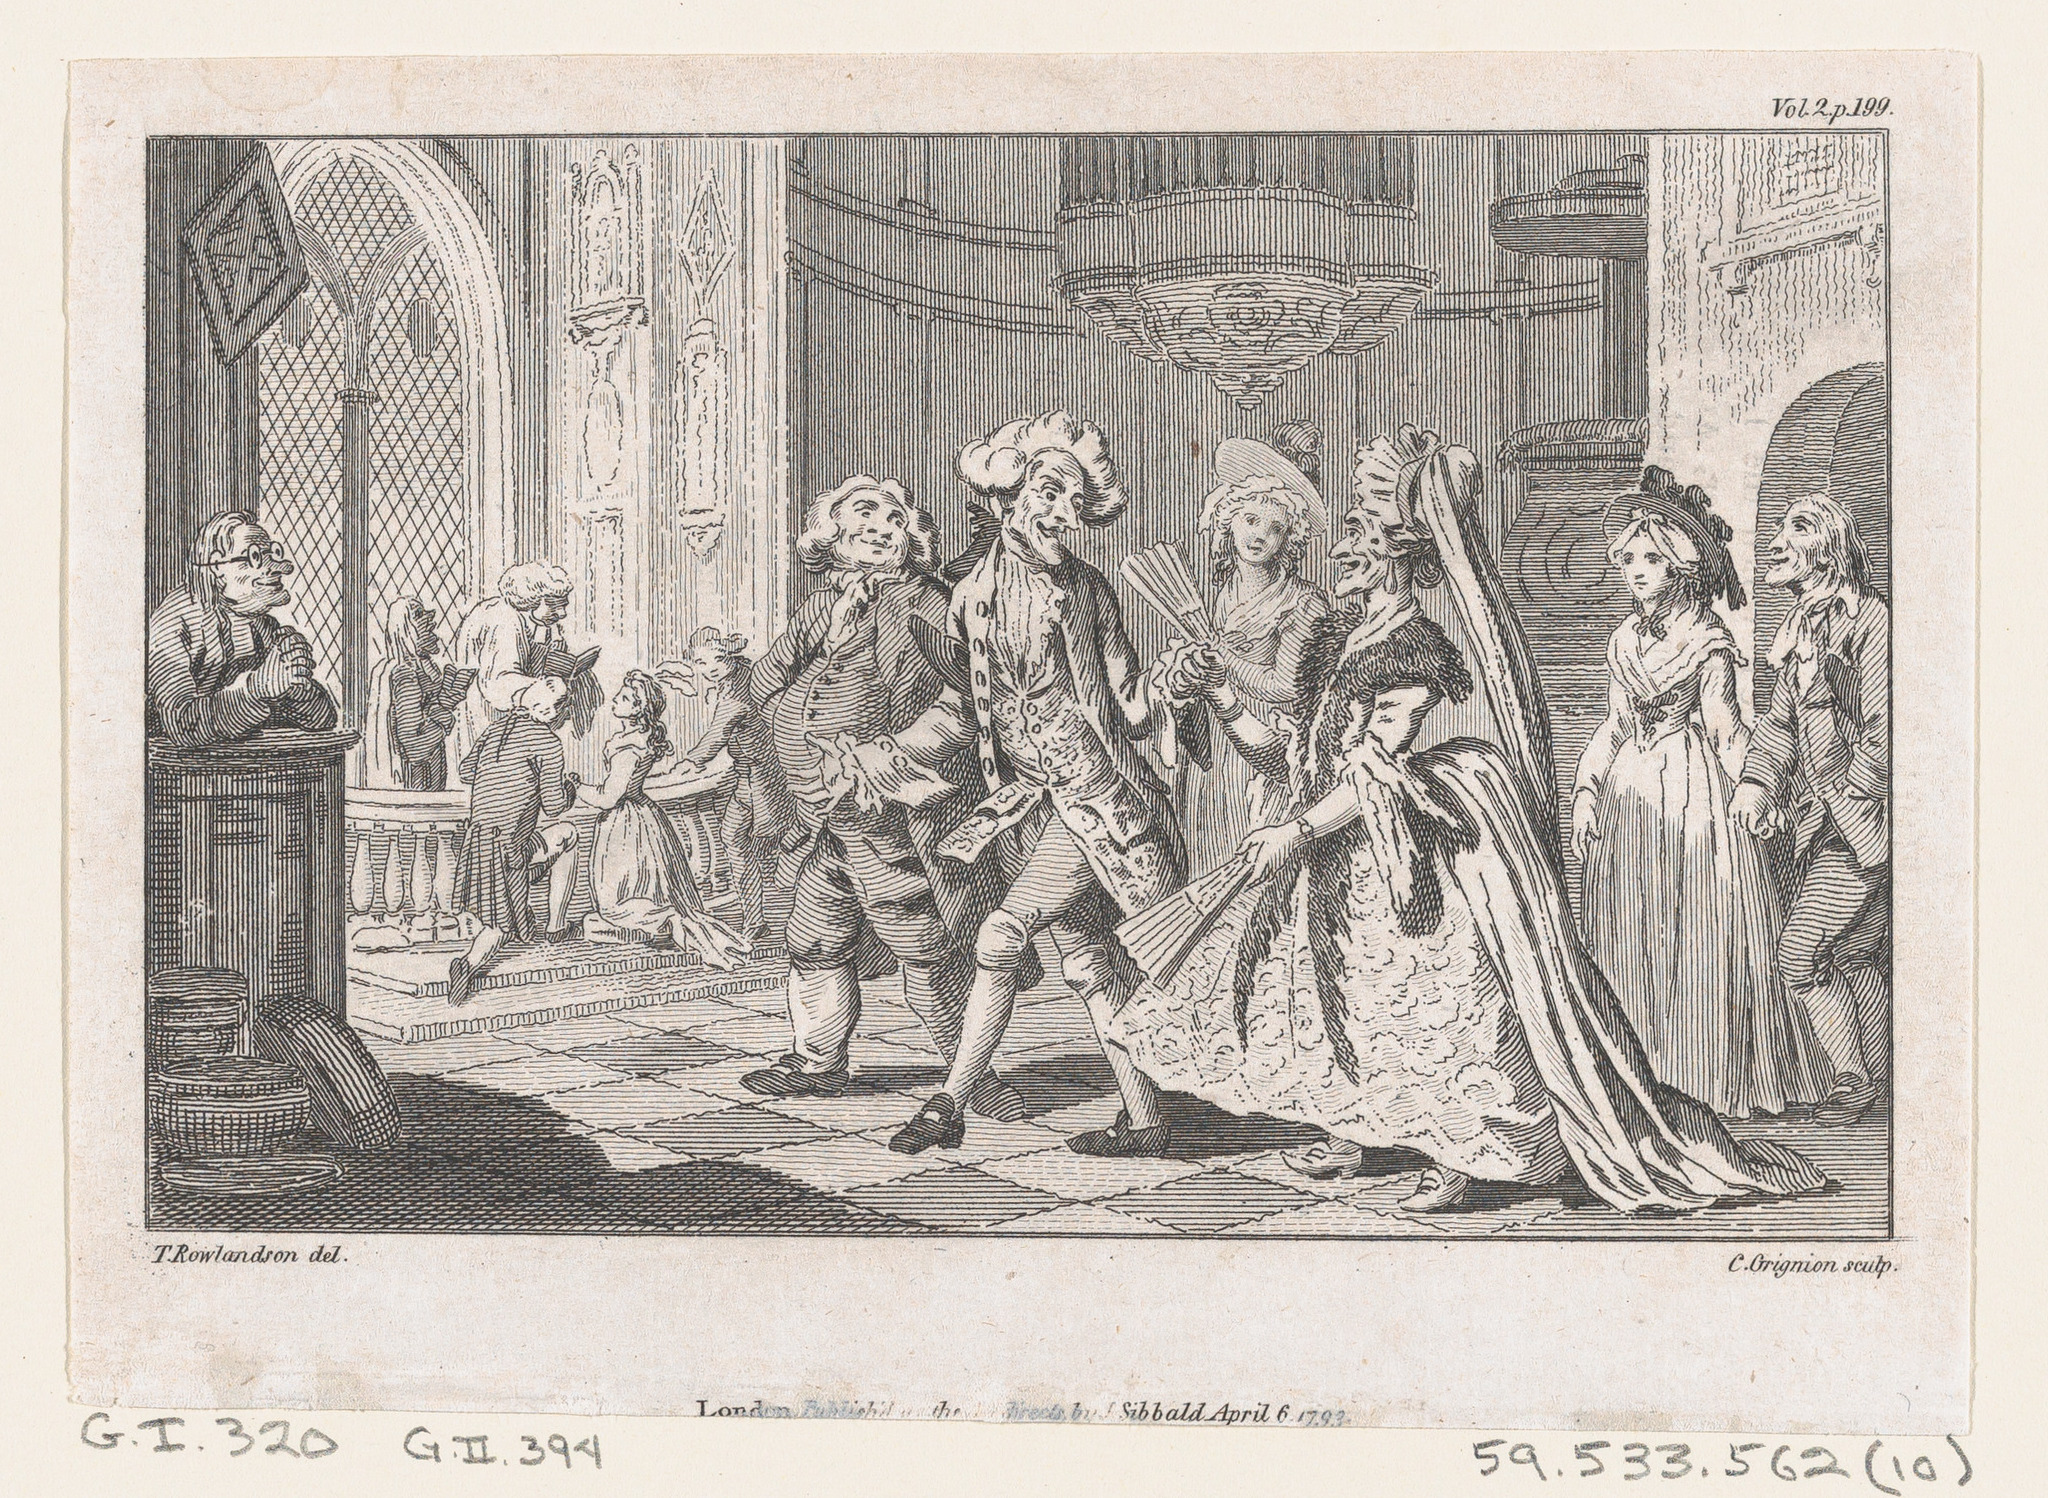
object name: print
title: The Wedding of Lismahago and Tabitha, an illustration from Tobias Smollett's "The Expedition of Humphry Clinker" (London, 1793), Vol. 1. 1793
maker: charles grignion, i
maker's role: artist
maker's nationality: british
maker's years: 1710-1810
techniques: engraving, etching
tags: men,women